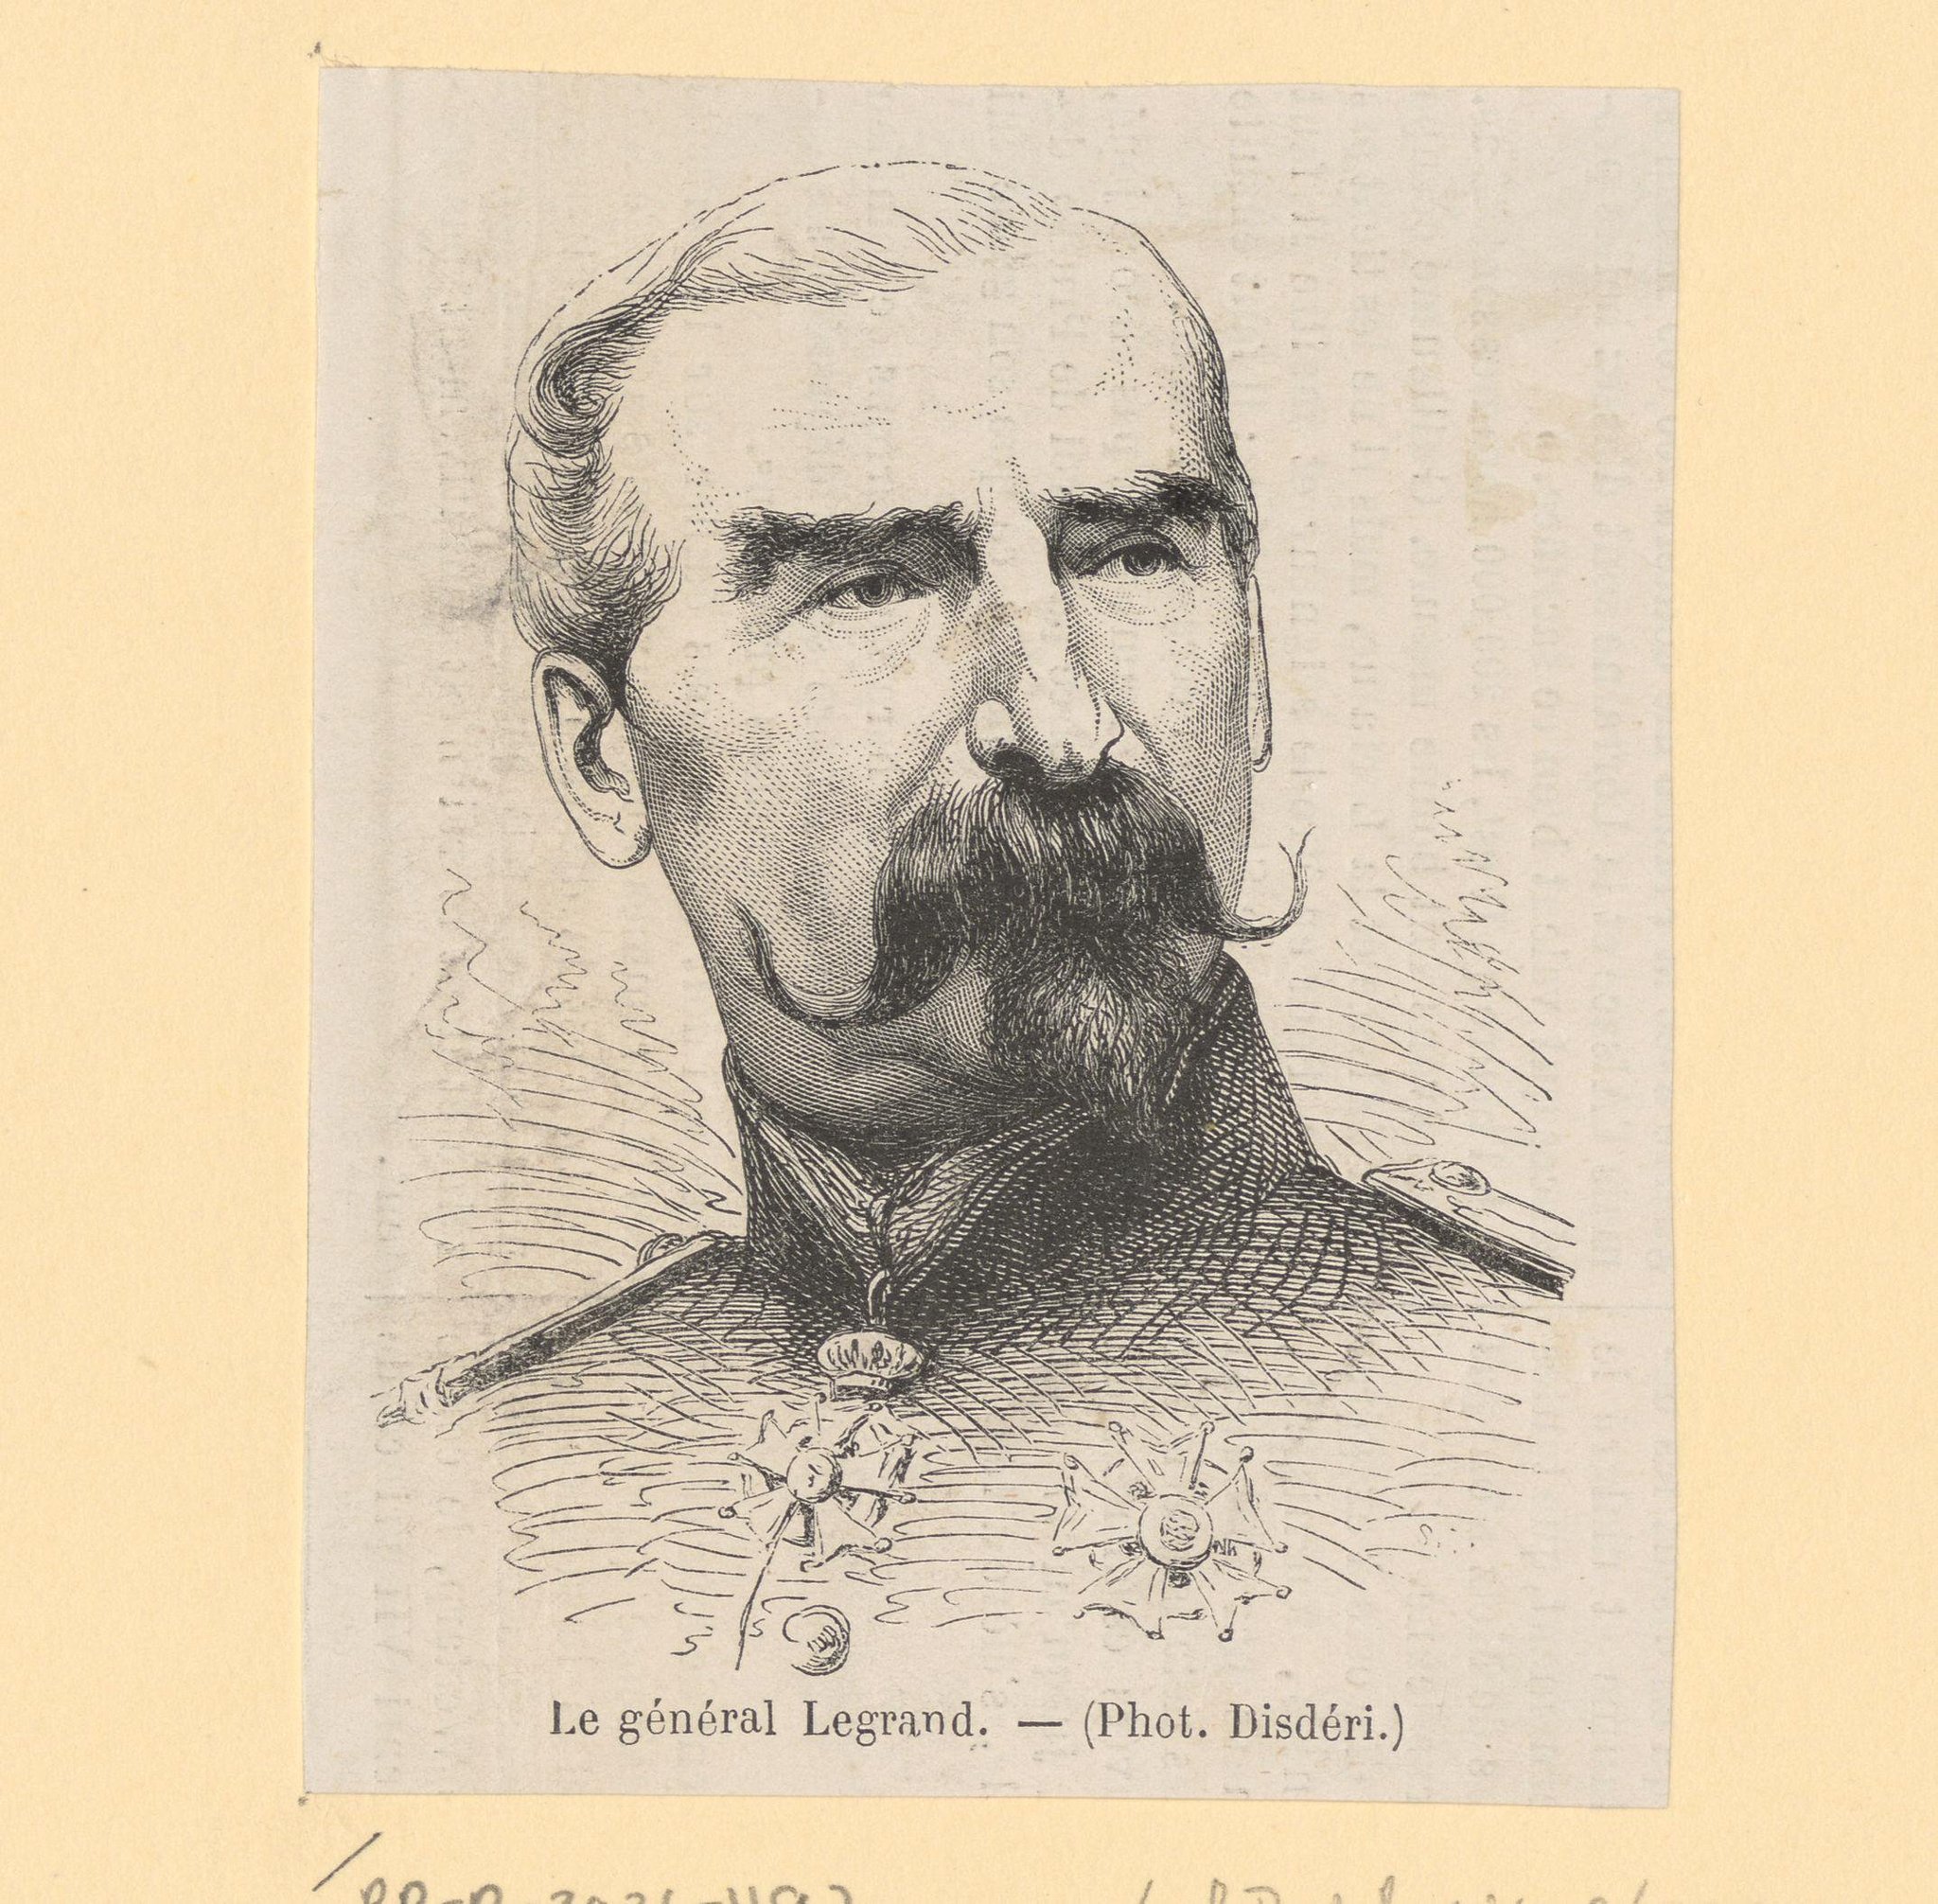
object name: print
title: Portret van Frédéric Legrand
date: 1870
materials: paper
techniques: letterpress printing, engraving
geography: paris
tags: commander-in-chief, general, marshal, historical persons, (military) uniforms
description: Prent uit: Le Monde Illustré 14 (1870), nr. 699, 3 september 1870, p. 149.